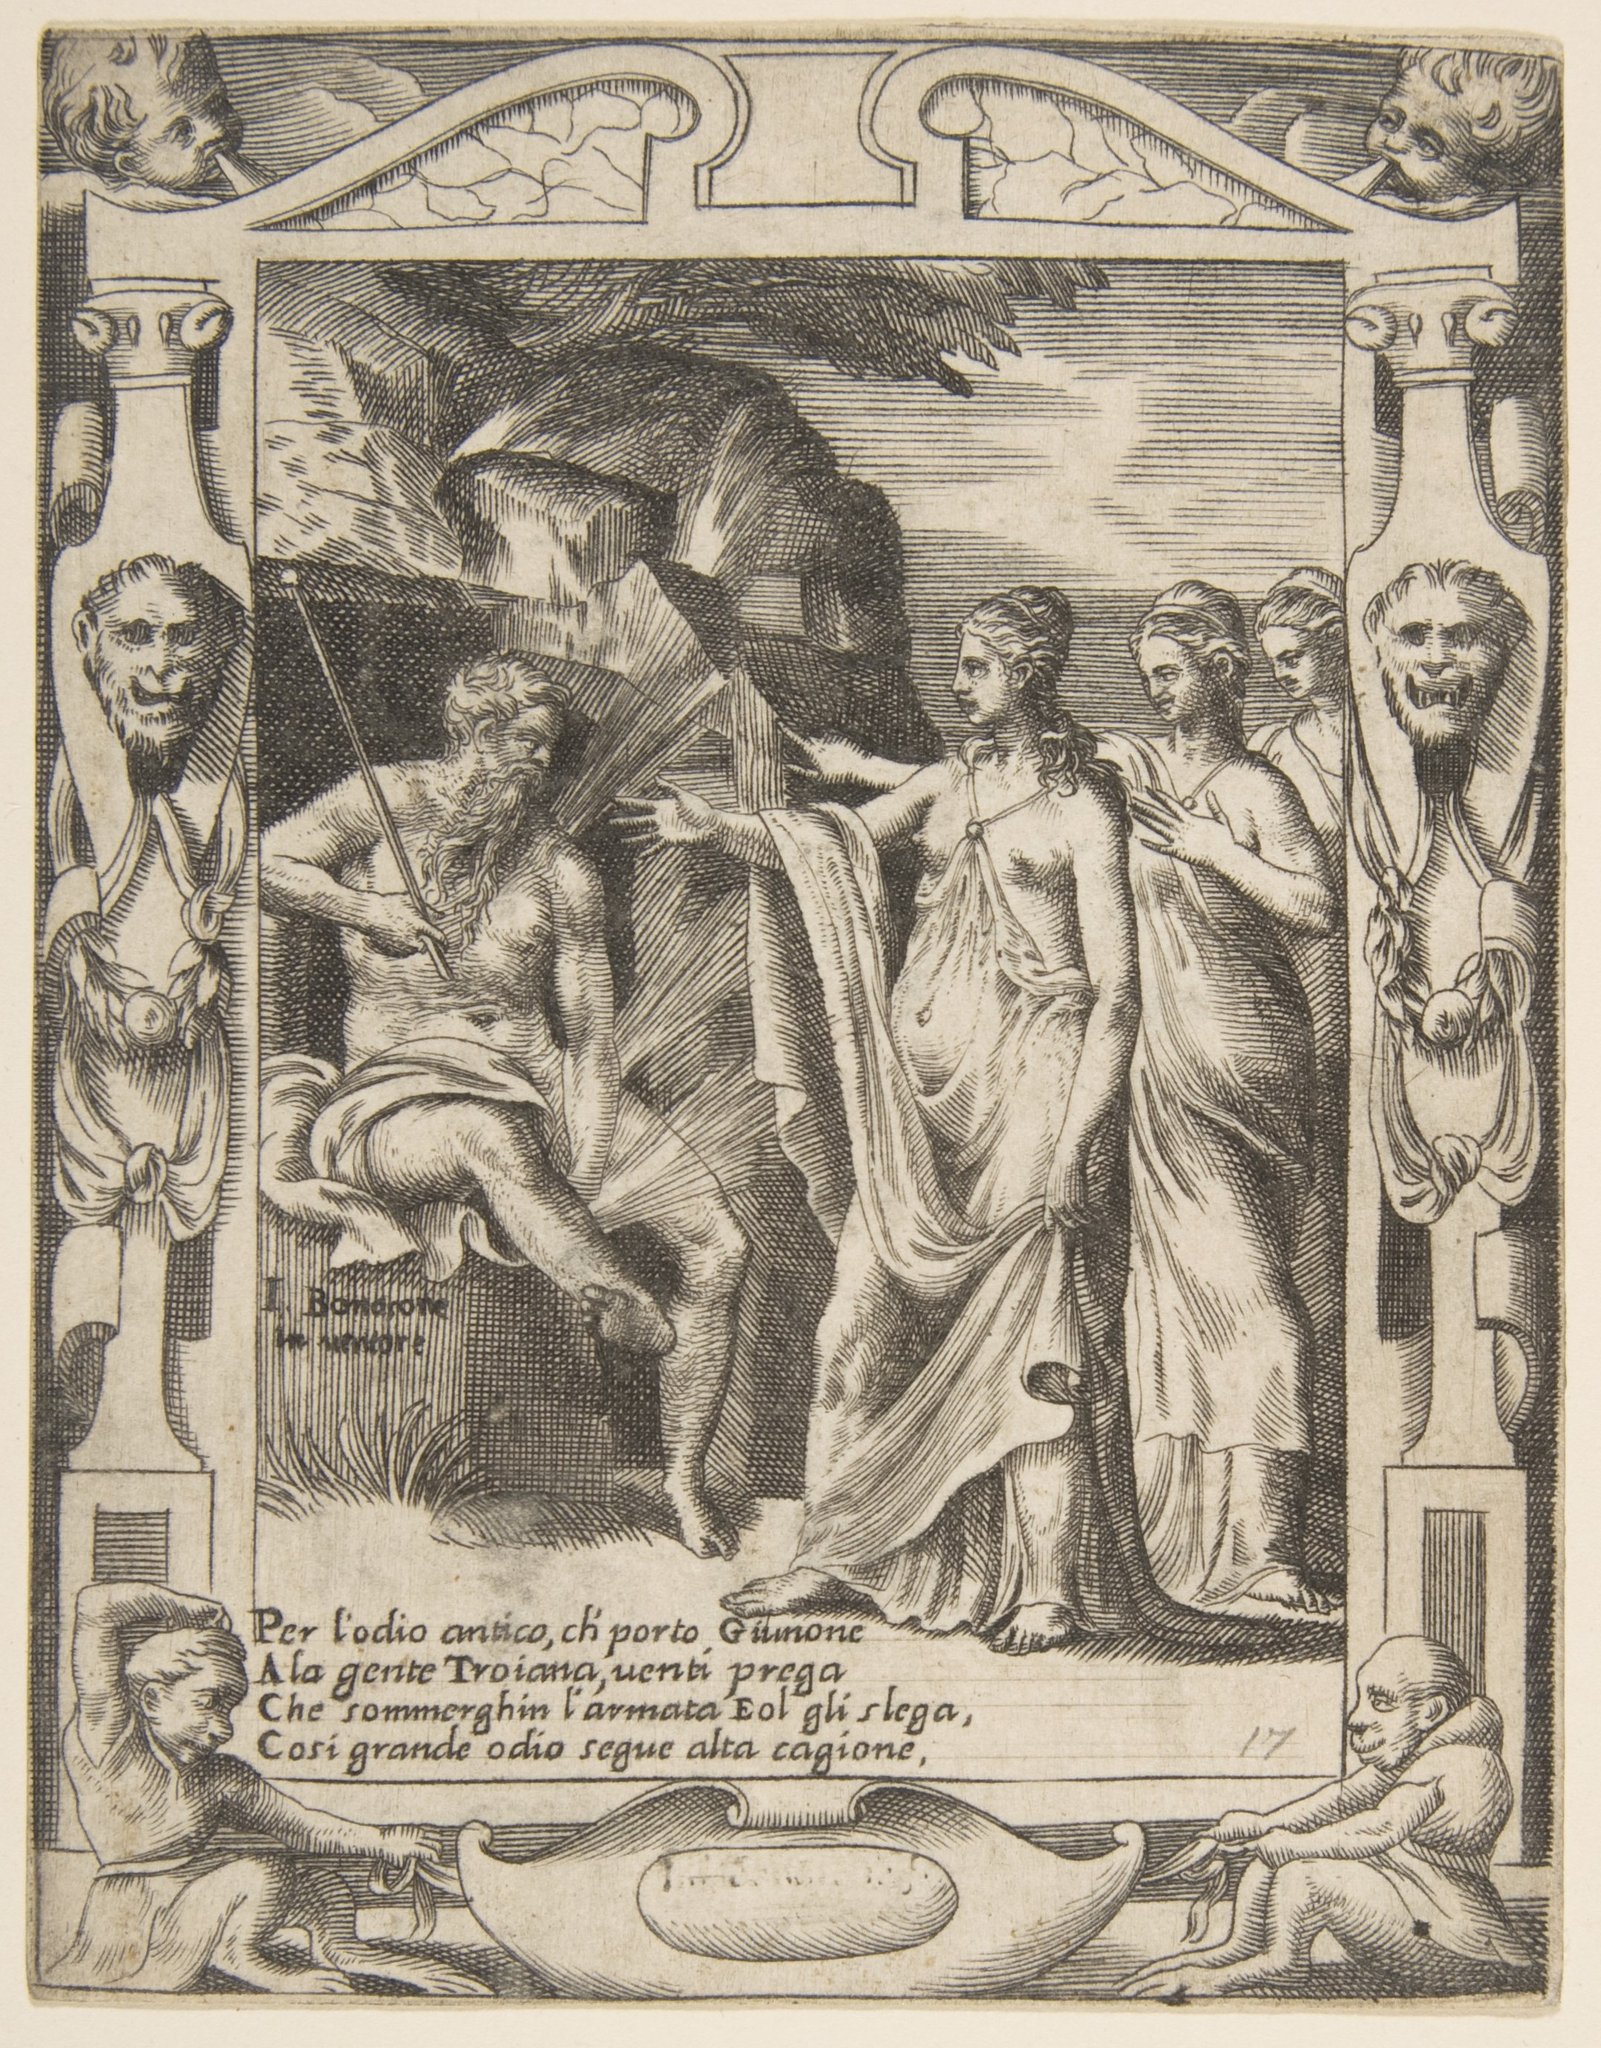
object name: print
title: Juno asks Aeolus to raise a storm against the Trojan fleet, set within an elaborate frame, from "Loves, Rages and Jealousies of Juno"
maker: giulio bonasone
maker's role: artist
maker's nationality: italian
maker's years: 1510-1576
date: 1531-1576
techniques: engraving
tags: women,juno